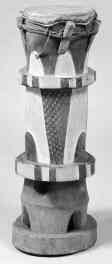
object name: mbejn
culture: fang people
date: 1801-1900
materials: wood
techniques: polychrome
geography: gabon